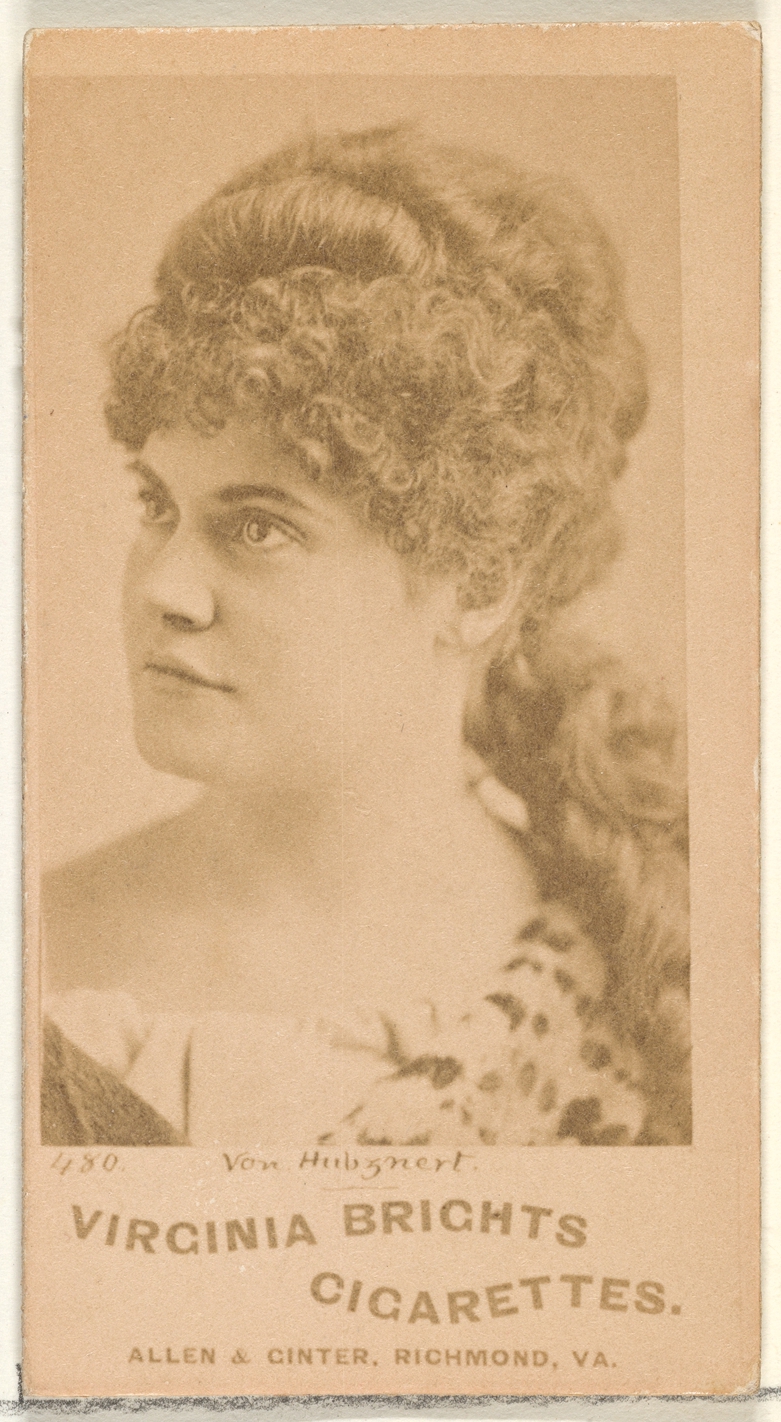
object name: photograph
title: Card 480, Von Hubgnert, from the Actors and Actresses series (N45, Type 1) for Virginia Brights Cigarettes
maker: allen & ginter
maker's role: publisher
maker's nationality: american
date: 1888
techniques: albumen silver print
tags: portraits,women,actresses